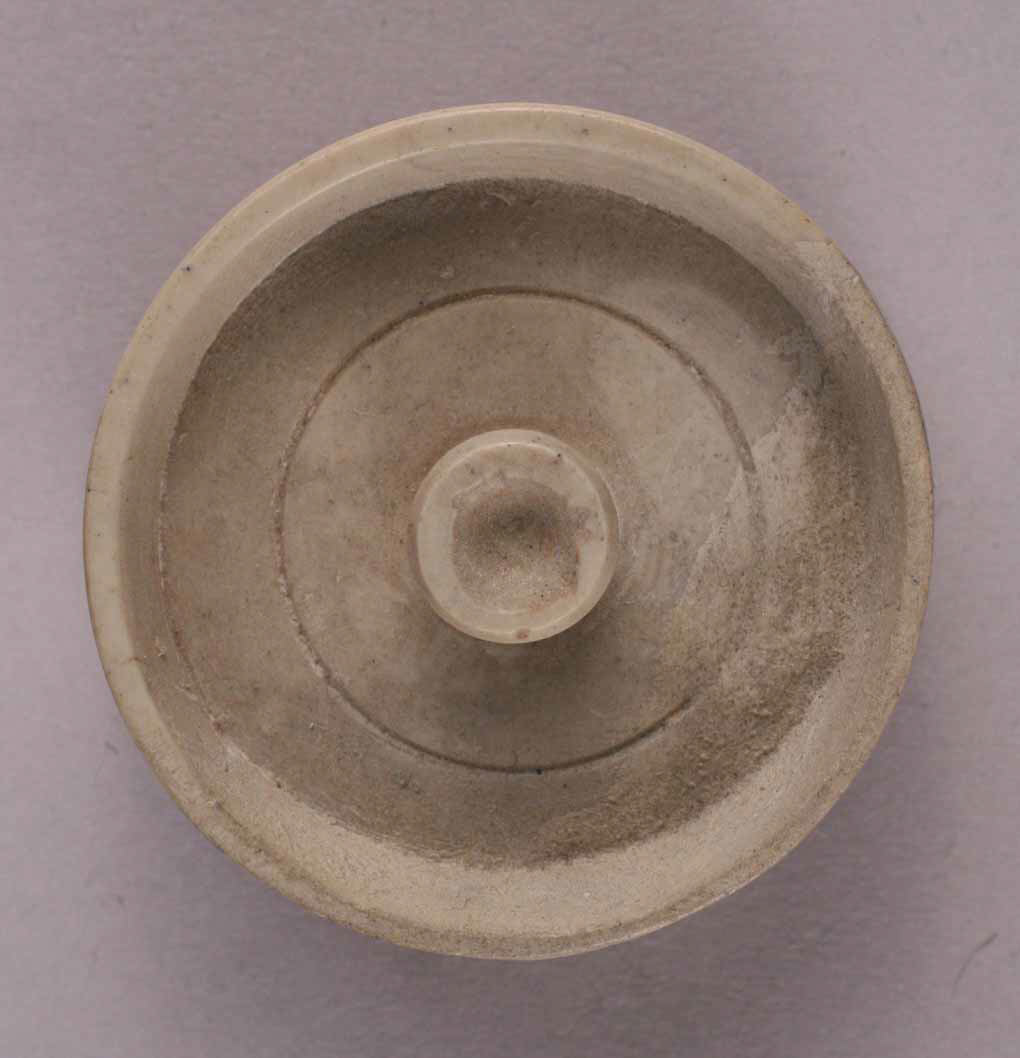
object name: lid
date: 801-1000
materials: stone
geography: iran